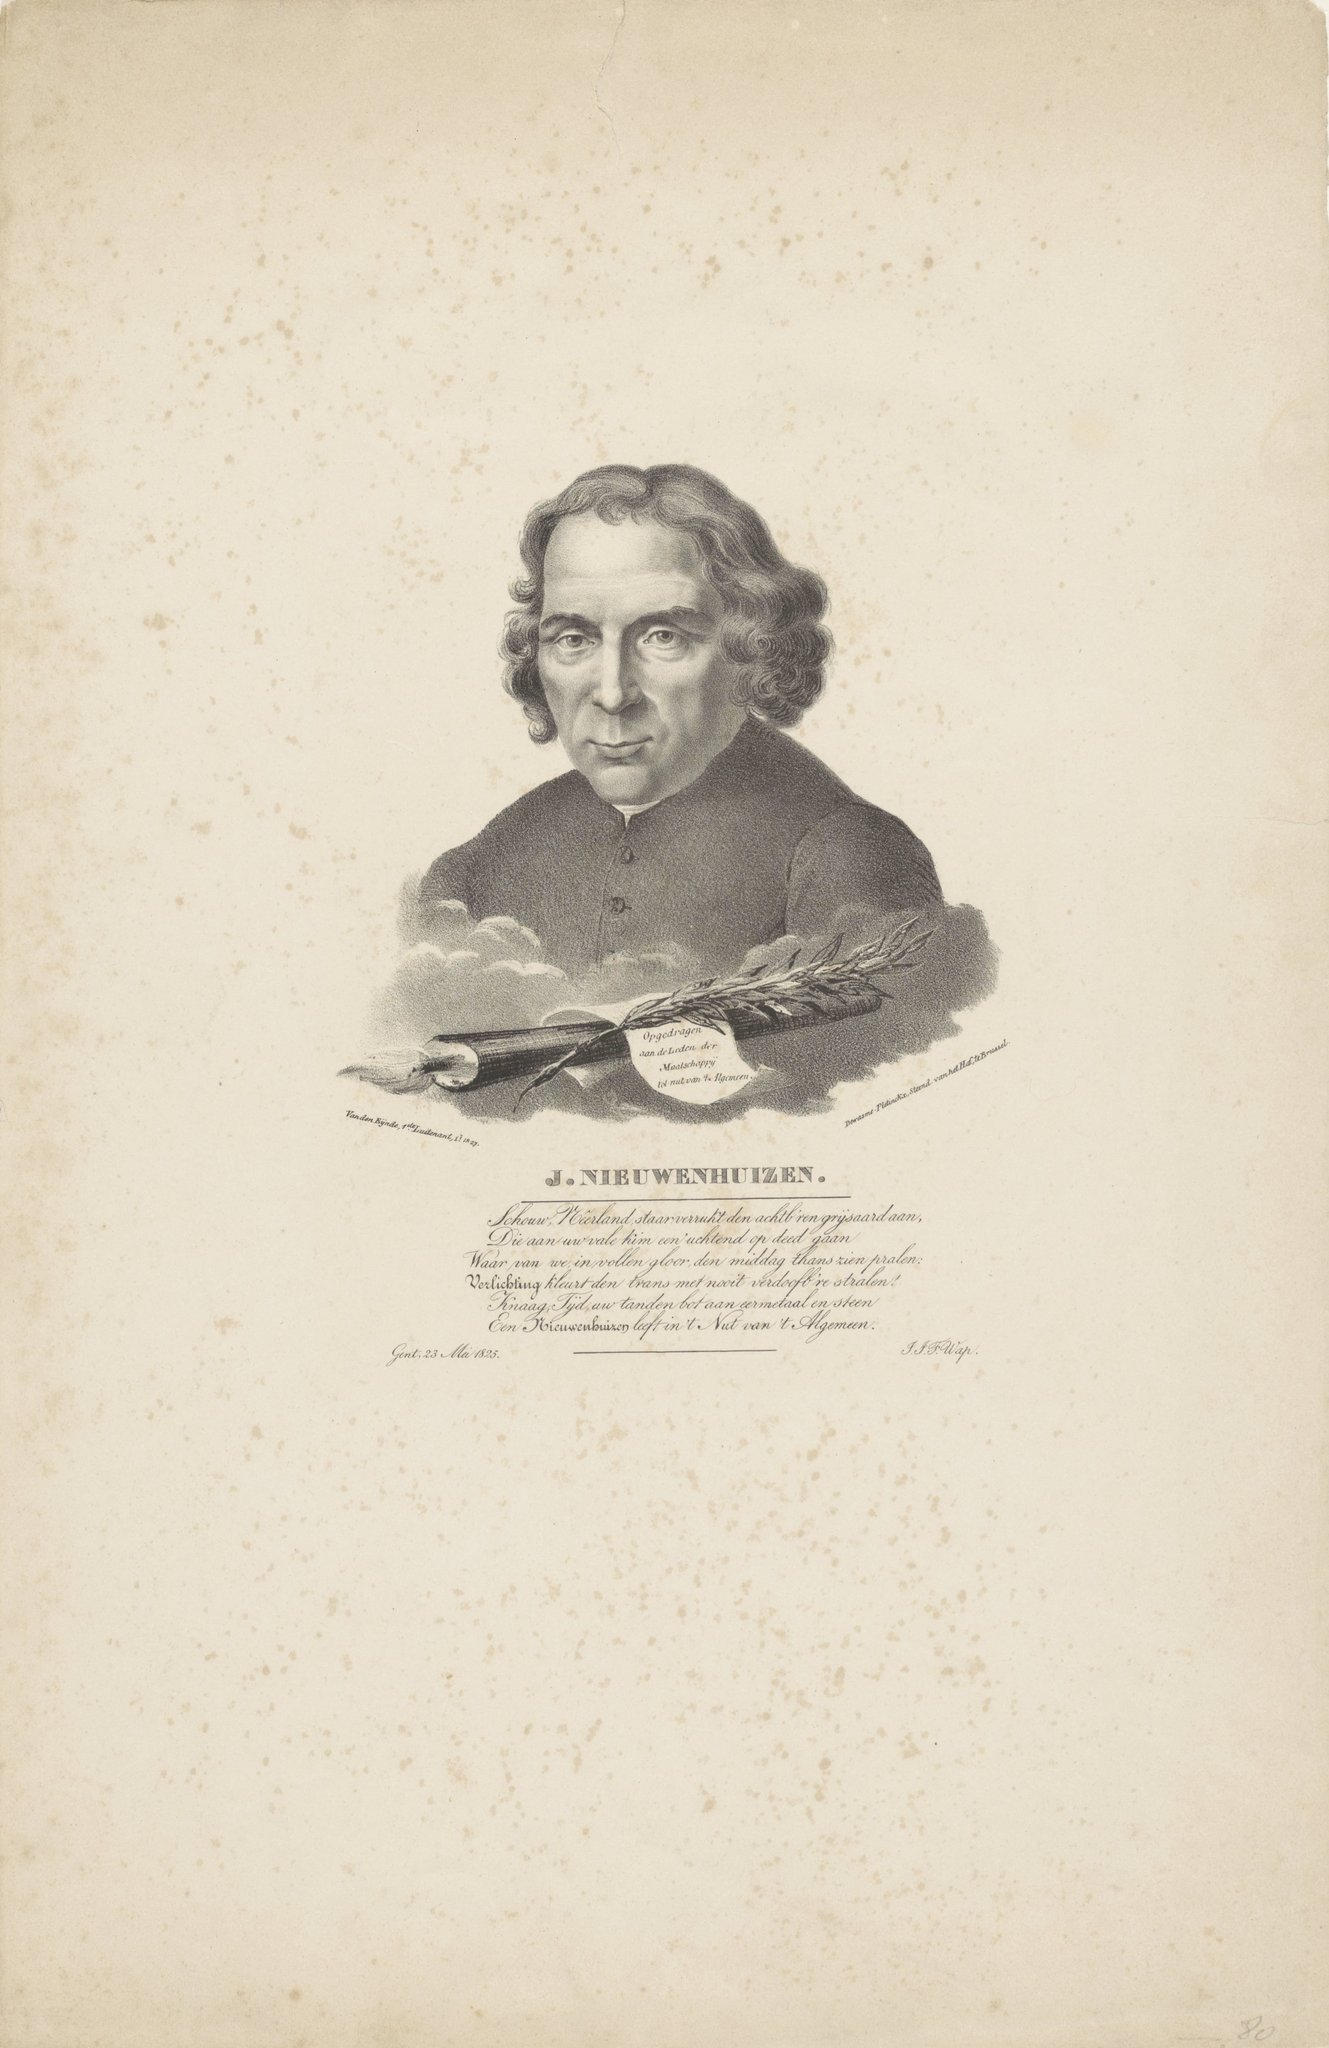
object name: print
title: Portret van Jan Nieuwenhuyzen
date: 1827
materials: paper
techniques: lithograph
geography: brussels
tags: haarlem, jan nieuwenhuyzen, torch, crowning with laurel, historical persons (+ (full) bust portrait)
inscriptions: collector's mark: Lugt 2228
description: De geportretteerde is afgebeeld boven een wolkenpartij, een fakkel, een lauwerkrans en een vel papier. Daaronder zijn naam en een zes regelig onderschrift door Johannes Jacobus Franciscus Wap.